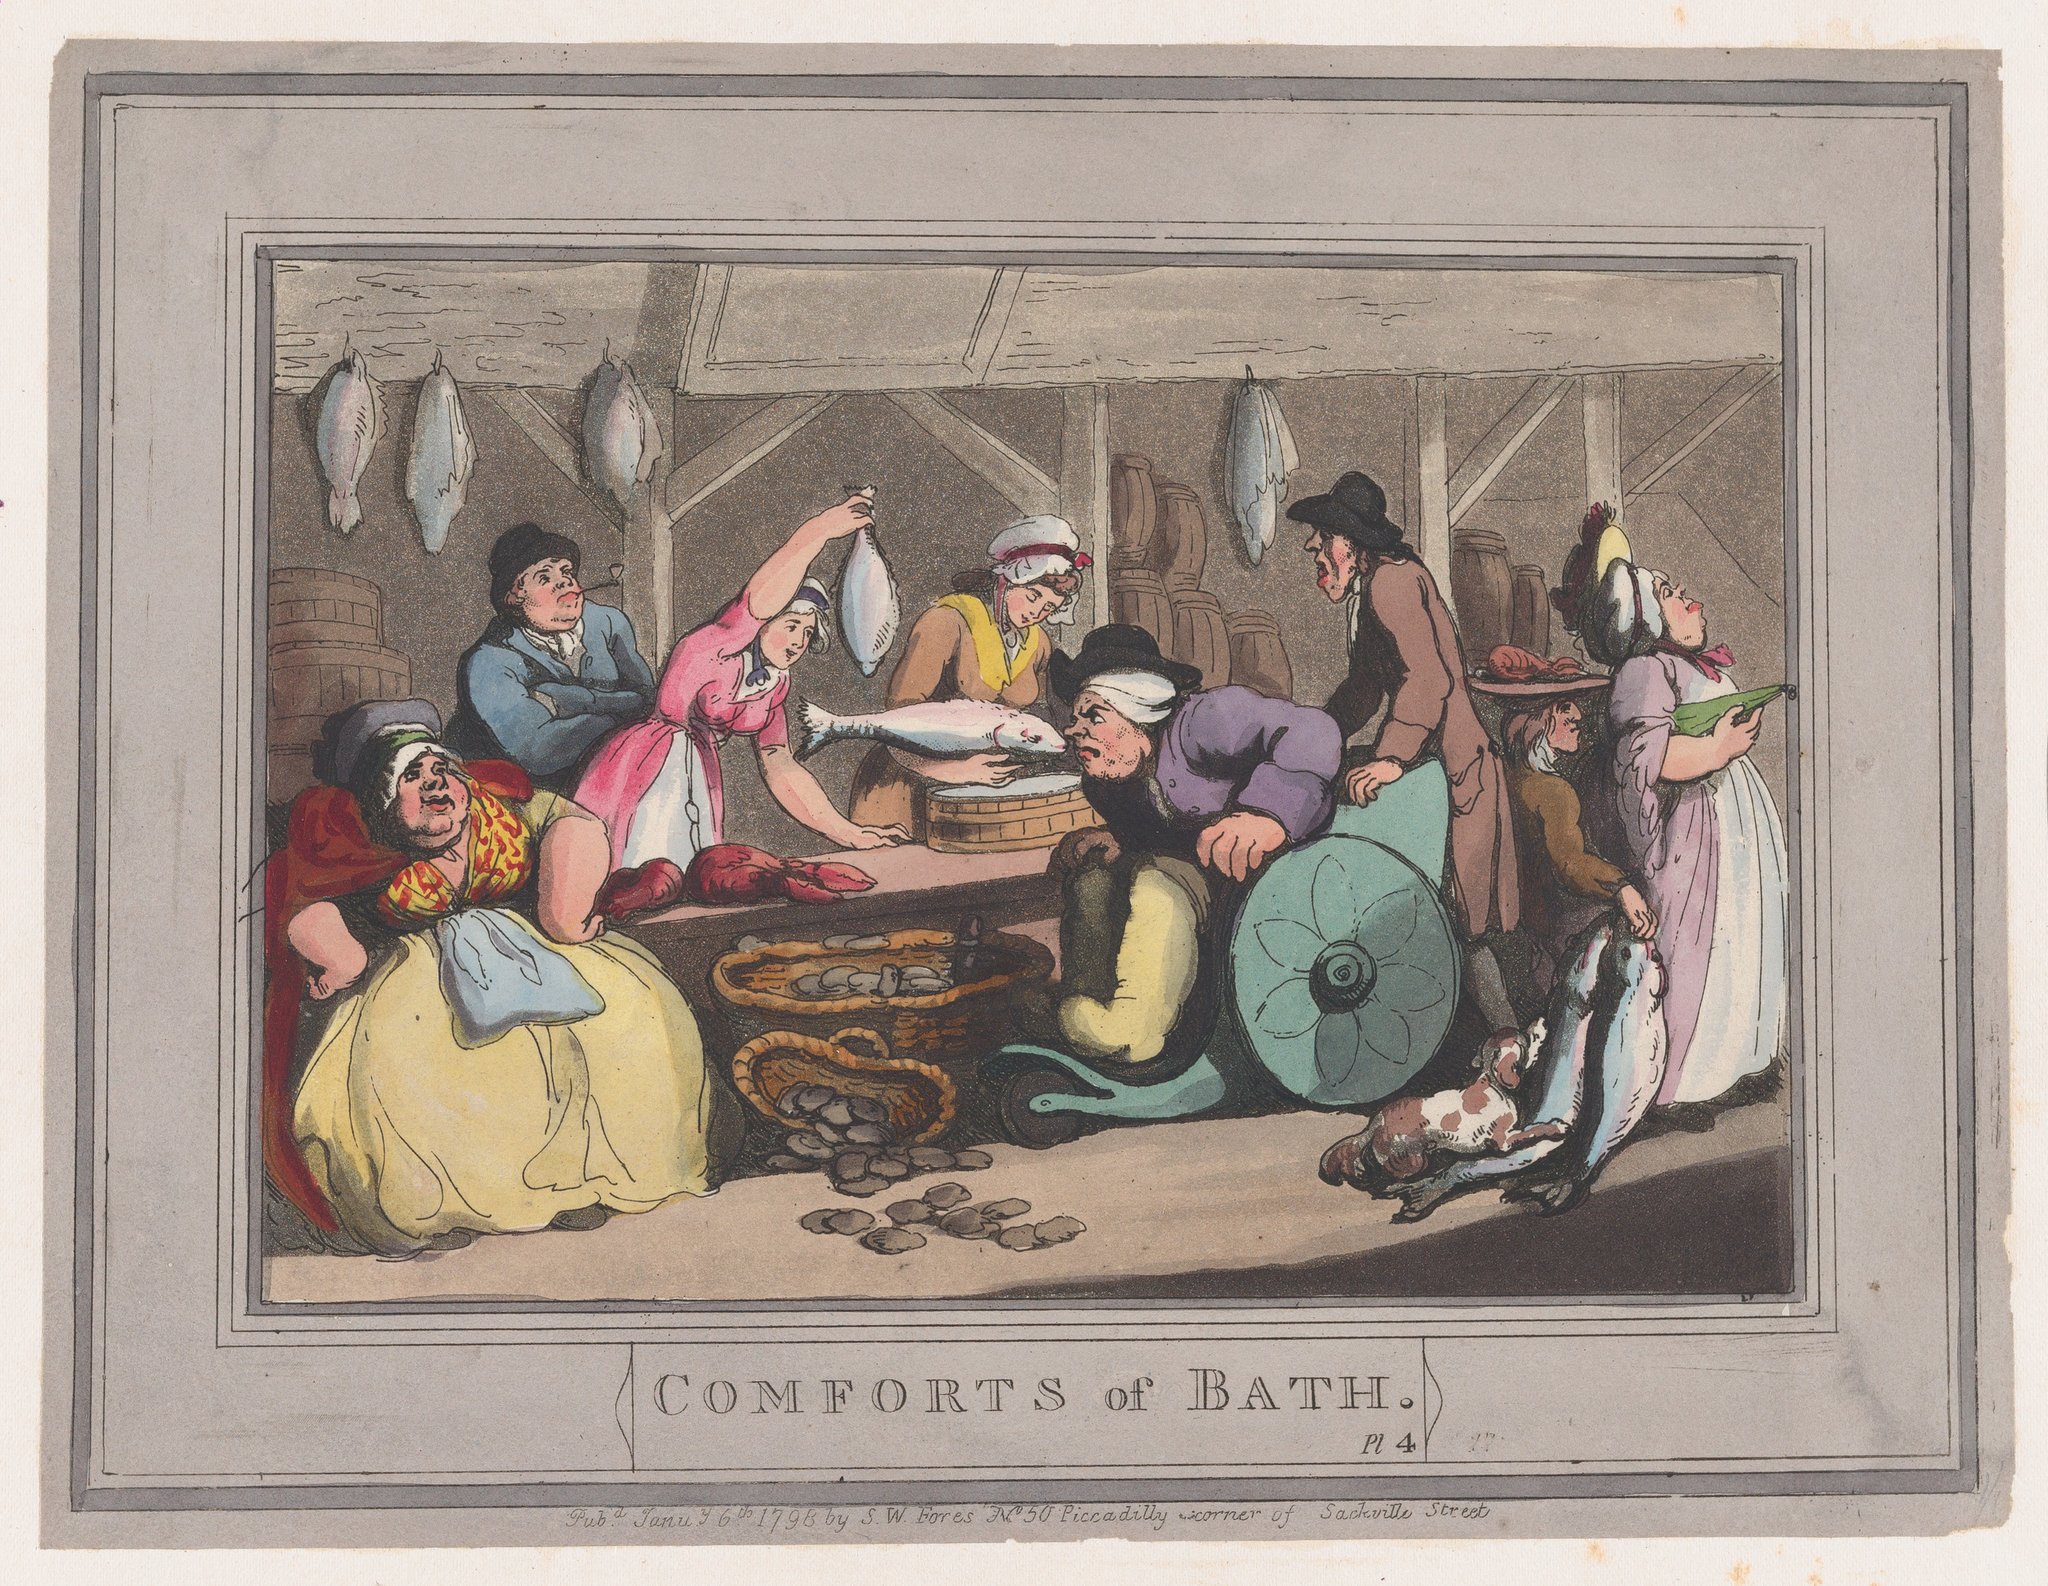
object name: print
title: Comforts of Bath, Plate 4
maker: thomas rowlandson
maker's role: artist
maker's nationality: british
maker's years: 1757-1827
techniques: aquatint, etching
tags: men,women,dogs,fish,markets